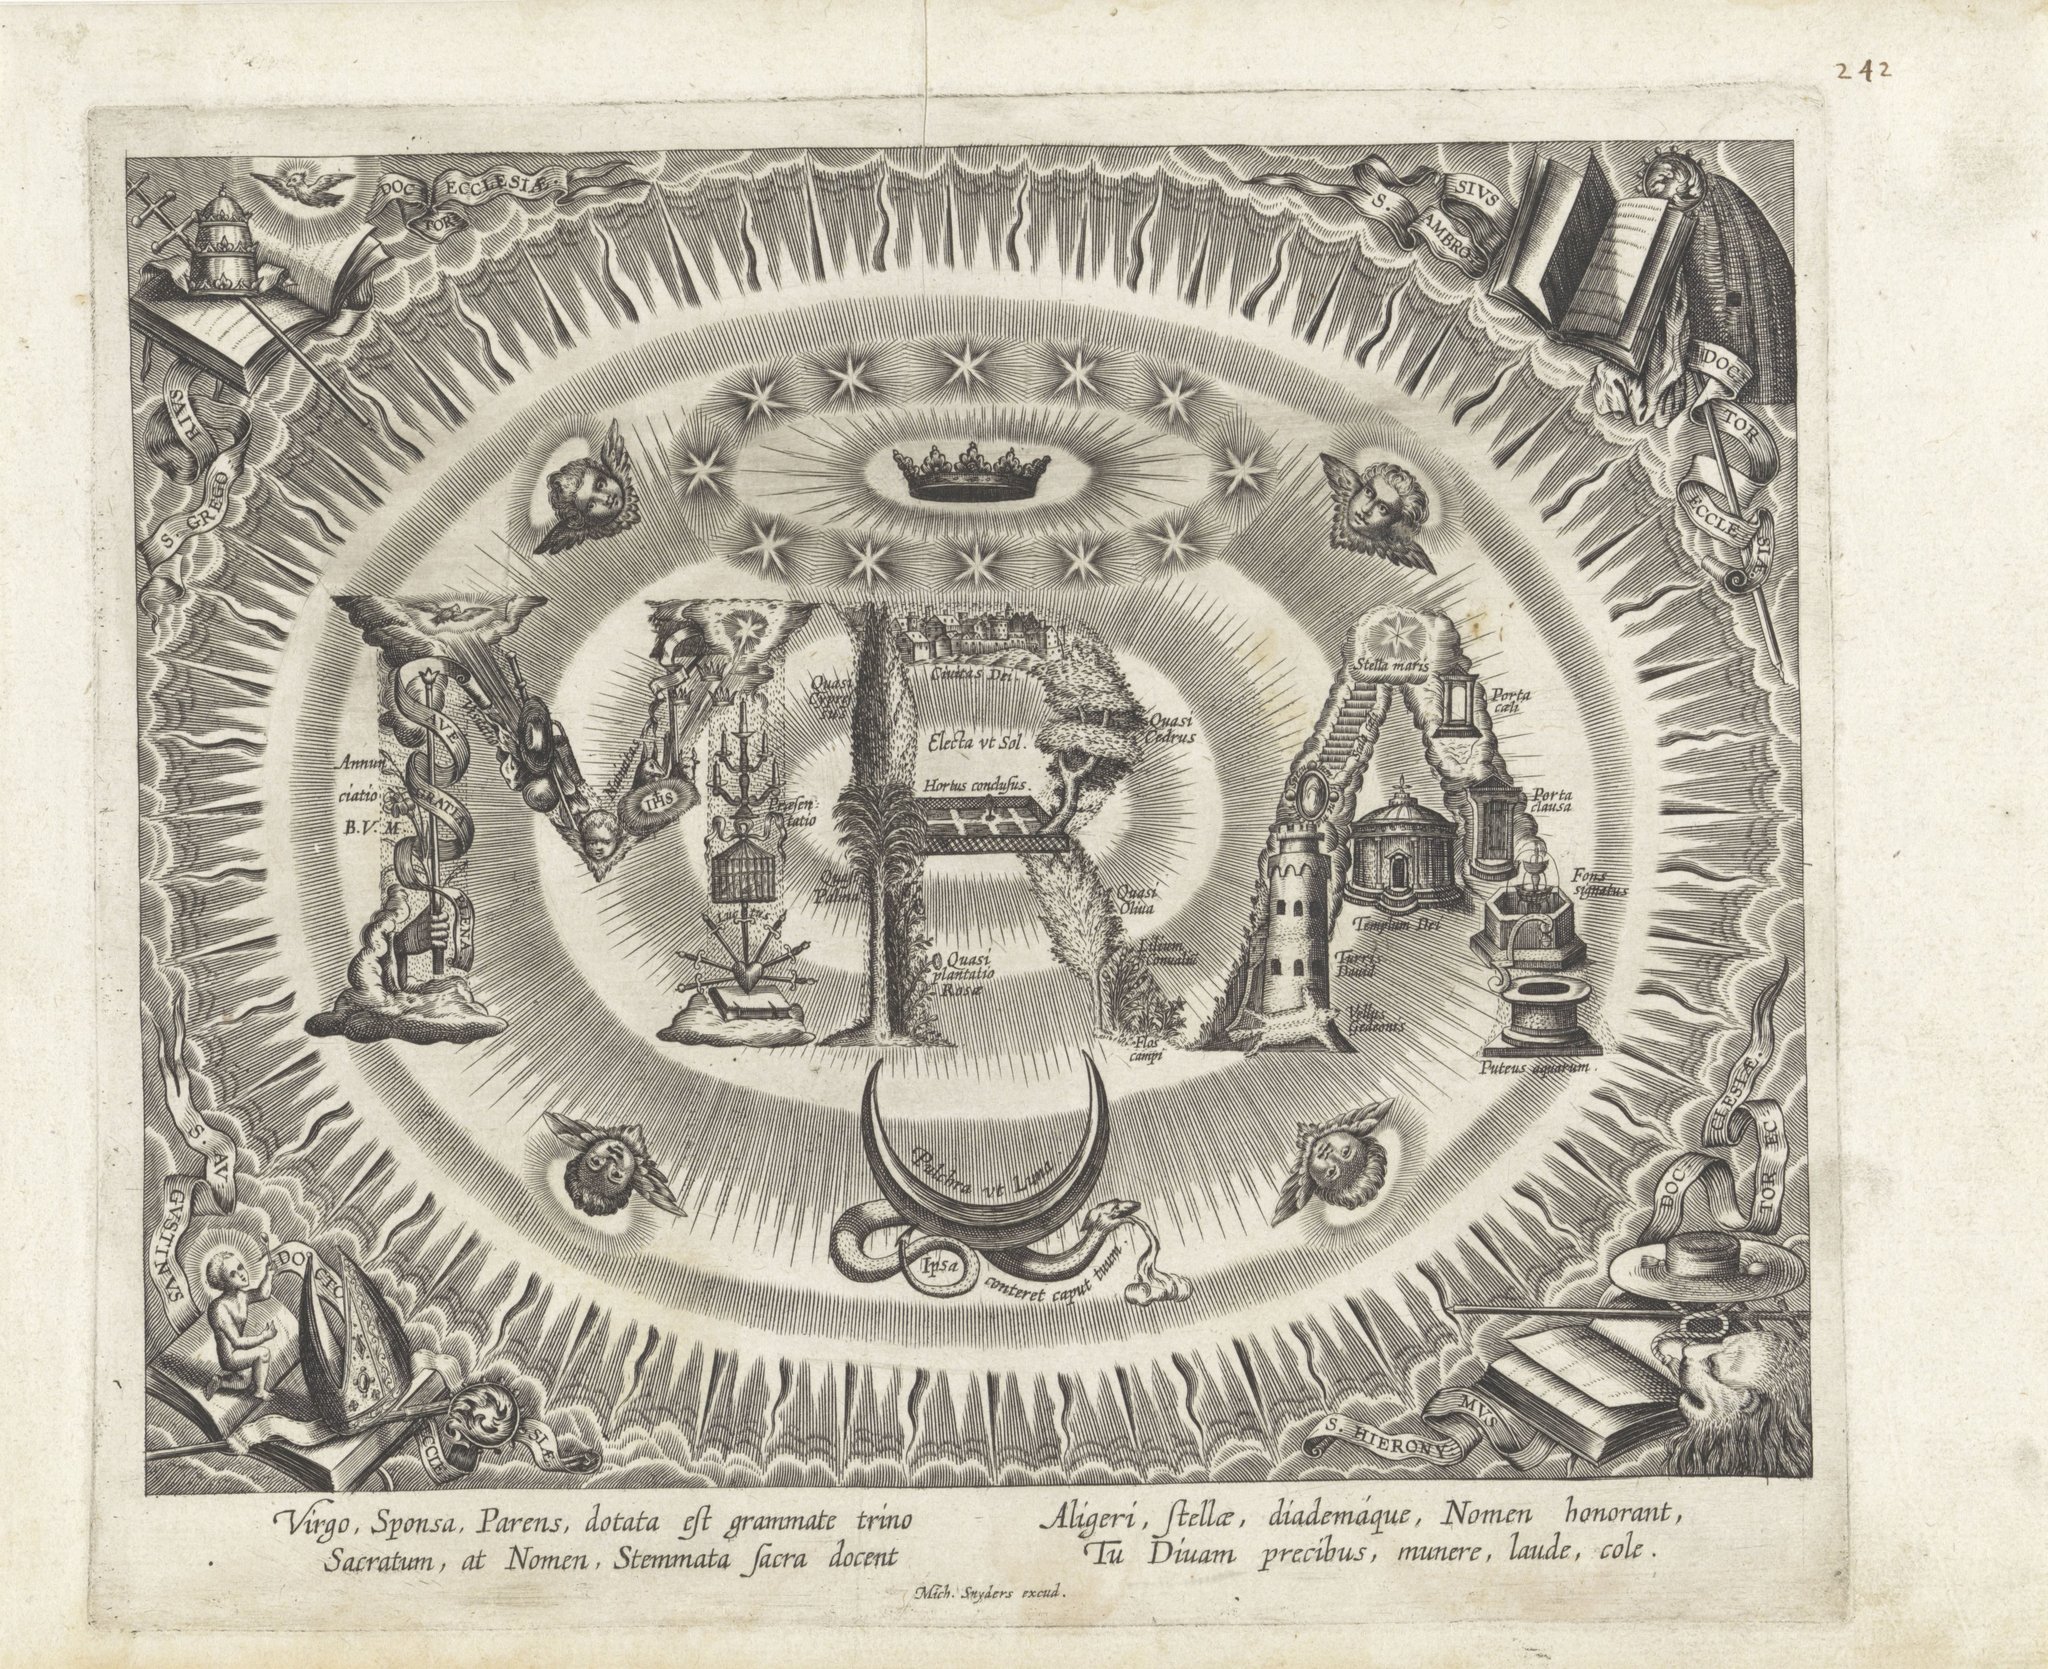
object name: ornament print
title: Ornament: Monogram van Maria: MRA opgebouwd uit Mariasymbolen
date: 1608-1630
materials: paper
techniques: engraving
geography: netherlands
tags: symbols of mary, monograms of mary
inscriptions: collector's mark: Lugt 2760, collector's mark: Lugt 2228, number: ‘242’, inscription: ‘S'il canto d'Orfeo rese vita all'ombre...riverenza’, inscription: ‘Virgo, Sponsa, Parens, dotata est grammate trino / Sacratum, at Nomen, Stemmata sacra docent // Aligreri, stellae, diademaque, Nomen honorant / Tu Divam precibus, munere, laude, cole.’, collector's mark: Lugt 3751, address: ‘Mich. Snijders excud.’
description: Monogram van Maria MRA, opgebouwd uit Mariasymbolen. De M bestaat uit de lelie met wimpel waarop Ave Maria gratia plena, de attributen die bij de geboorte van Christus en van zijn presentatie in de tempel horen en een hart, doorstoken met de 7 zwaarden (7 smarten van Maria). De R bestaat uit de ' civitas dei' , de 'hortus conclusus', de palmboom en andere bomen. De A bestaat uit de Templum Dei, de Turris Davidica, Porta Caeli, Porta Clausa, de Fons Signatus, Scala Caeli en Stella Maris. Boven de R een kroon in een krans van sterren, eronder de halve maan met de slang. Het geheel in krans van vuur met in de hoeken de attributen van de vier kerkvaders.